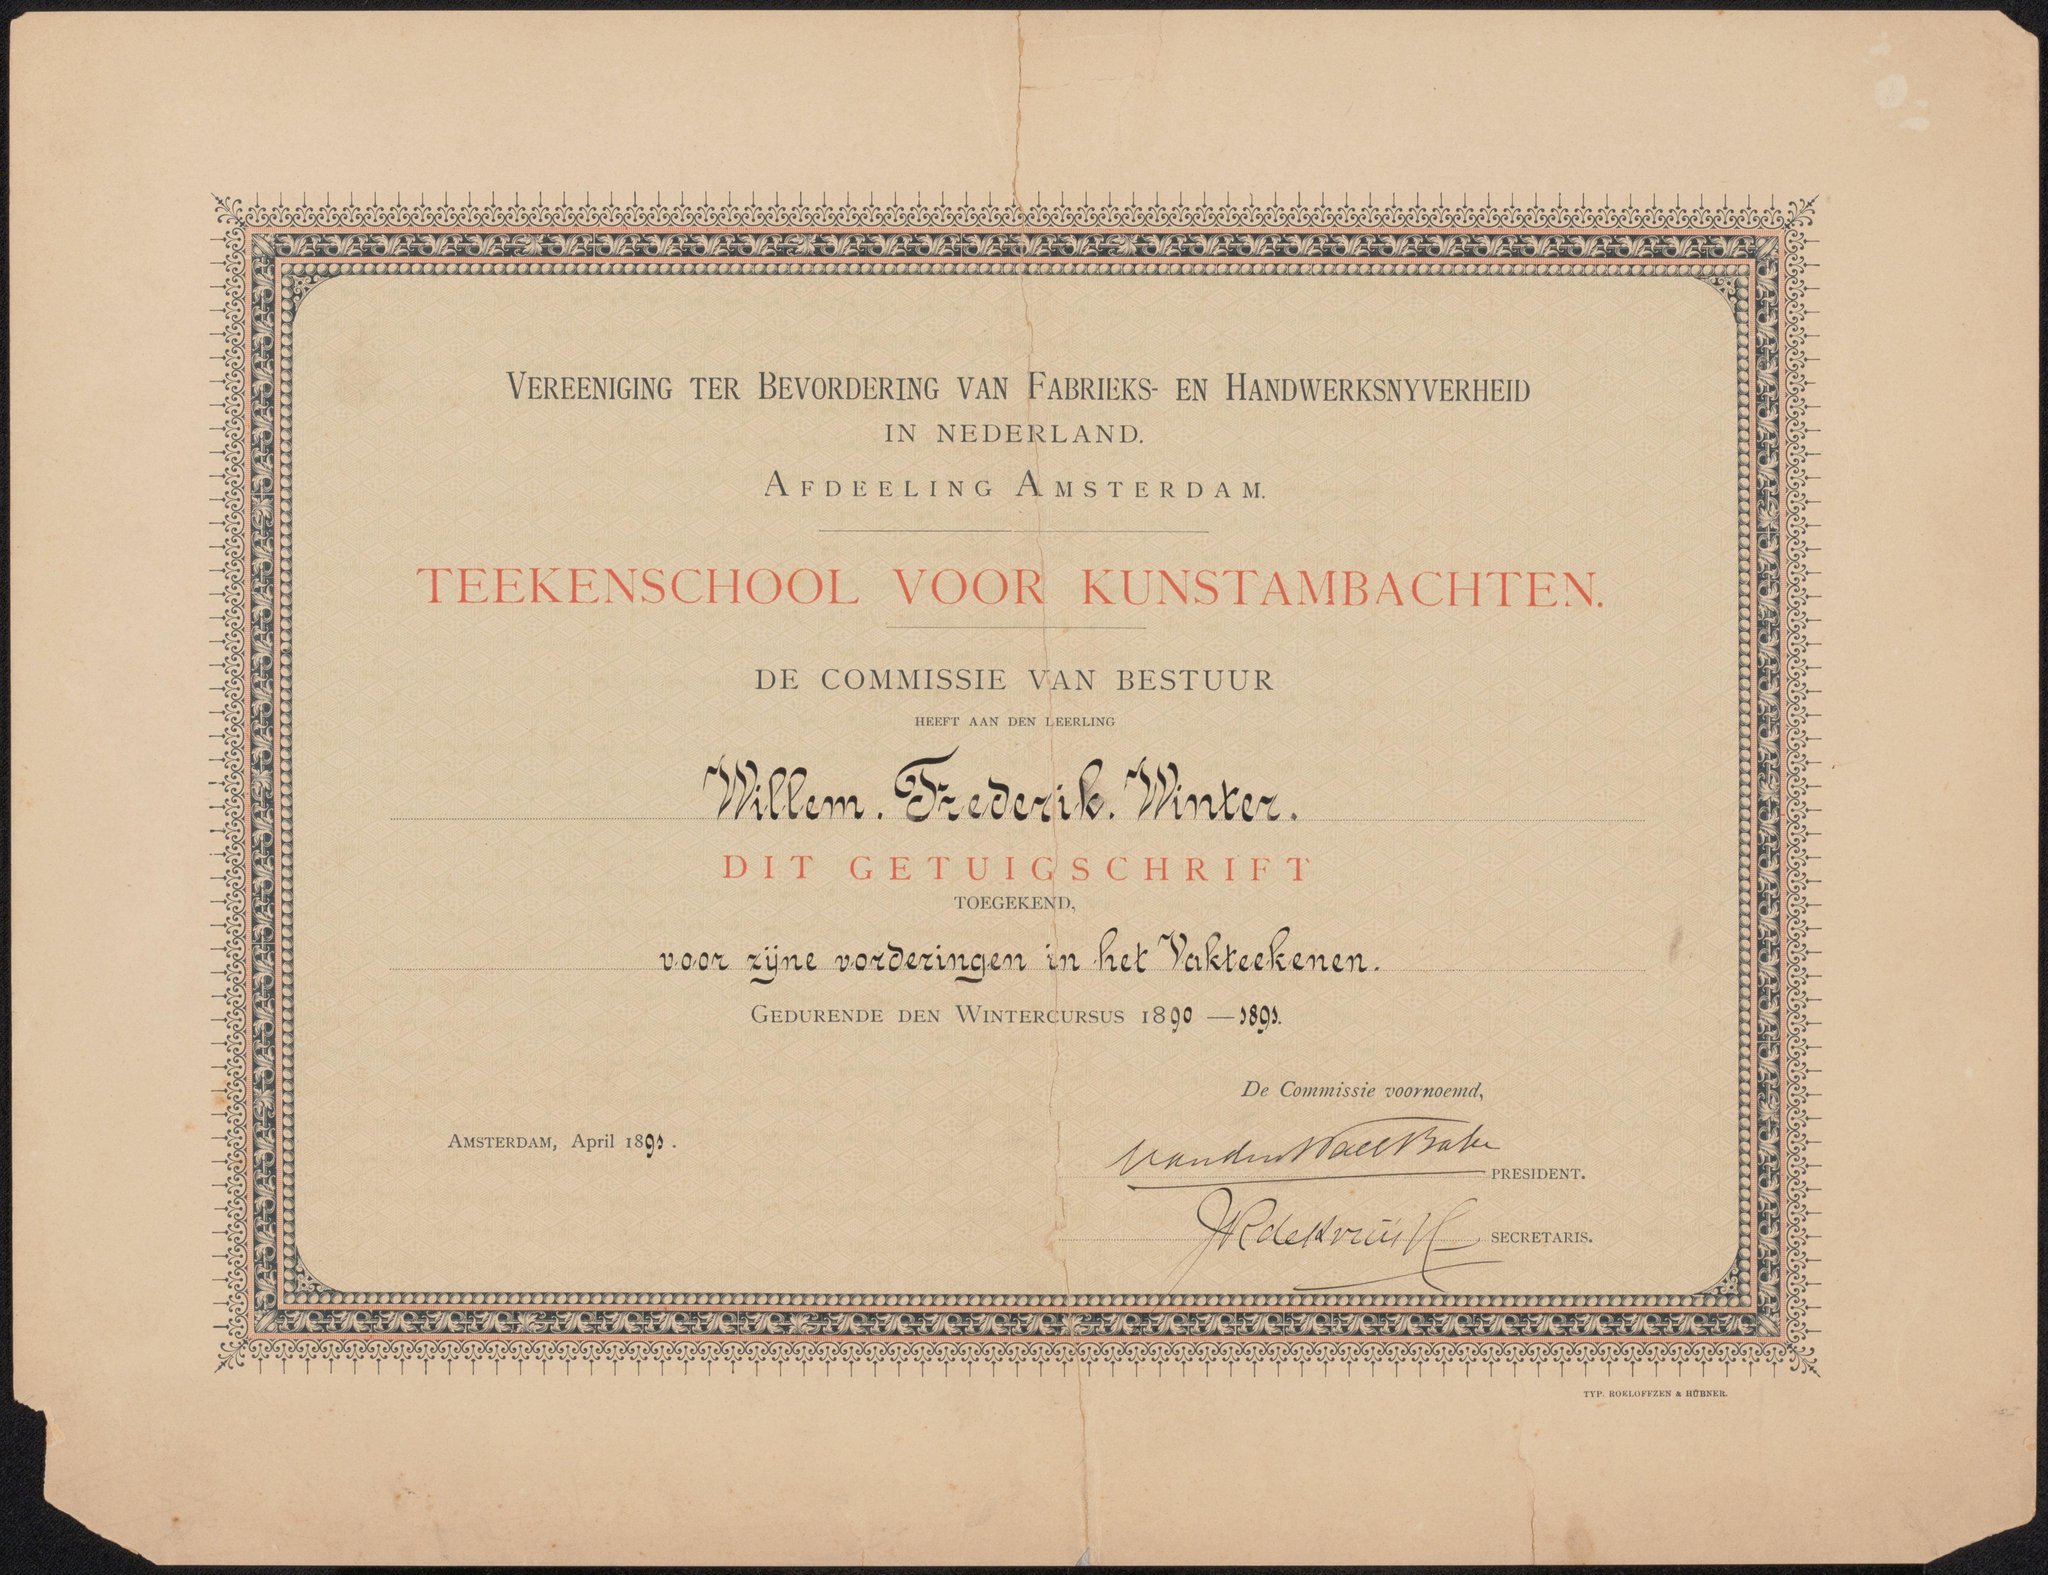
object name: testimonial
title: Getuigschrift voor Willem Frederik Winter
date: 1804-1891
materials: ink, paper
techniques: pen, printing, writing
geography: amsterdam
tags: painter, draughtsman, willem frederik winter, education, tuition of the artist (in general)